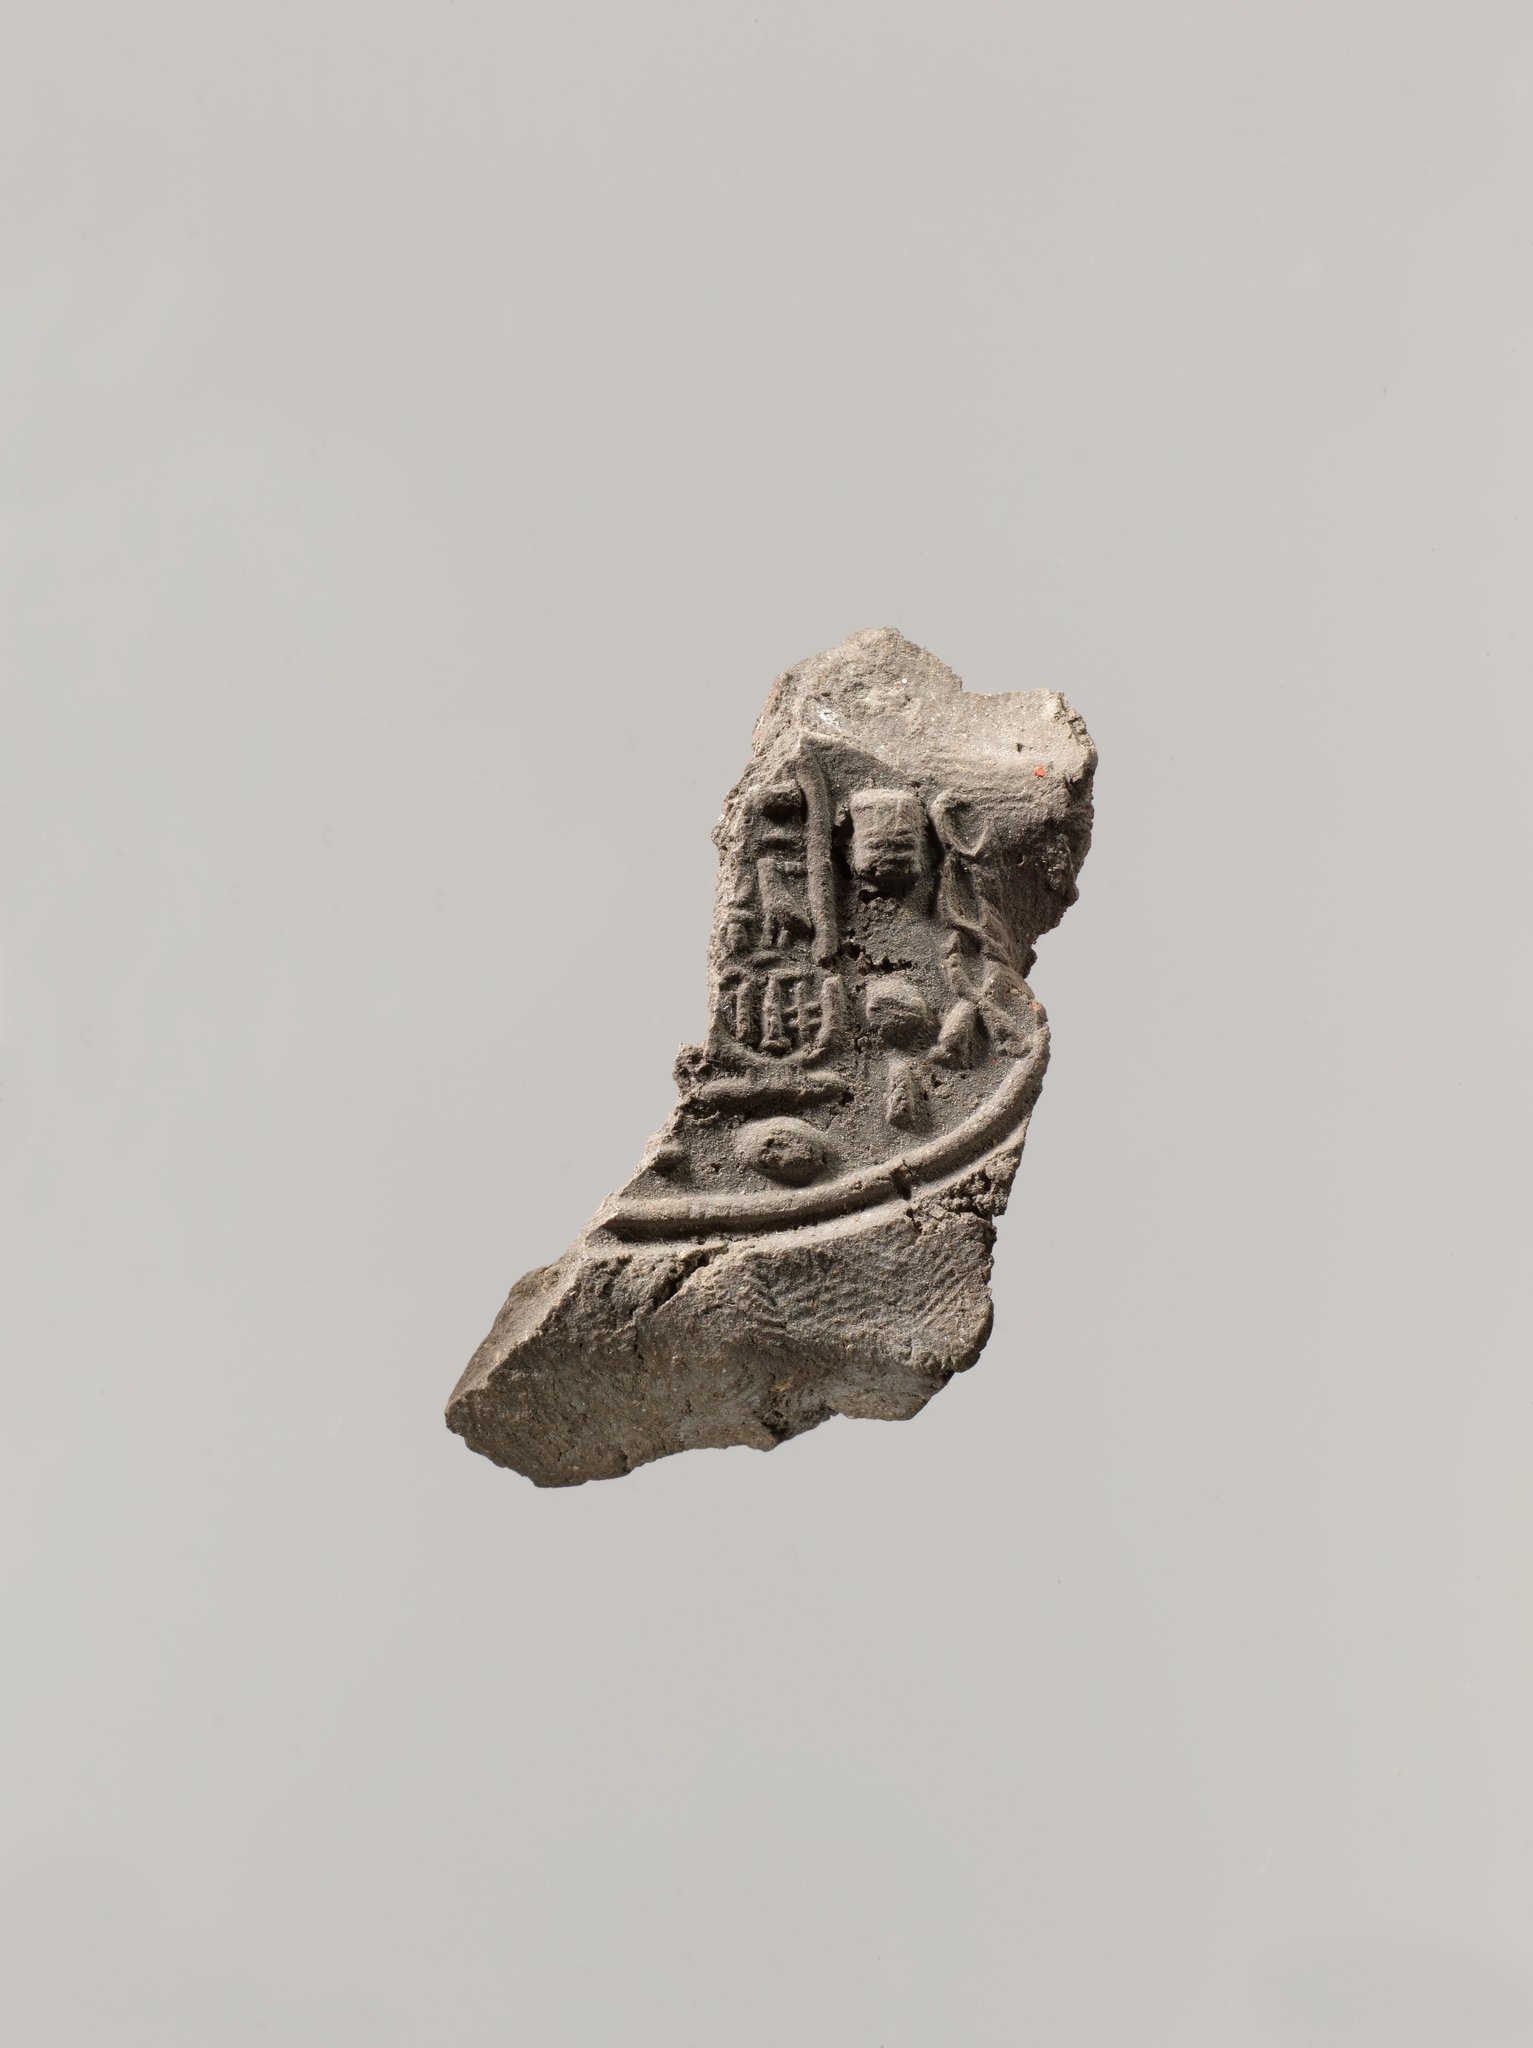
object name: seal impression, tutankhamun, beloved of ptah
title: Fragmentary Seal Impression from Tutankhamun's Embalming Cache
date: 1336-1327 BCE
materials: mud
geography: egypt